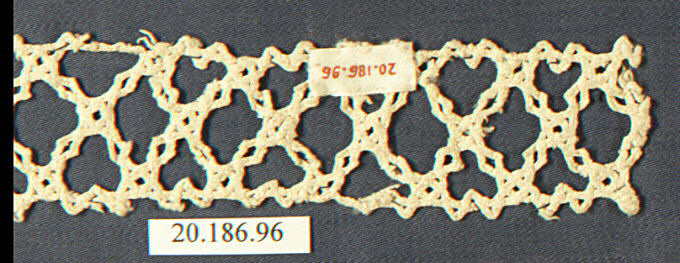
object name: insertion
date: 1501-1600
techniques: lace